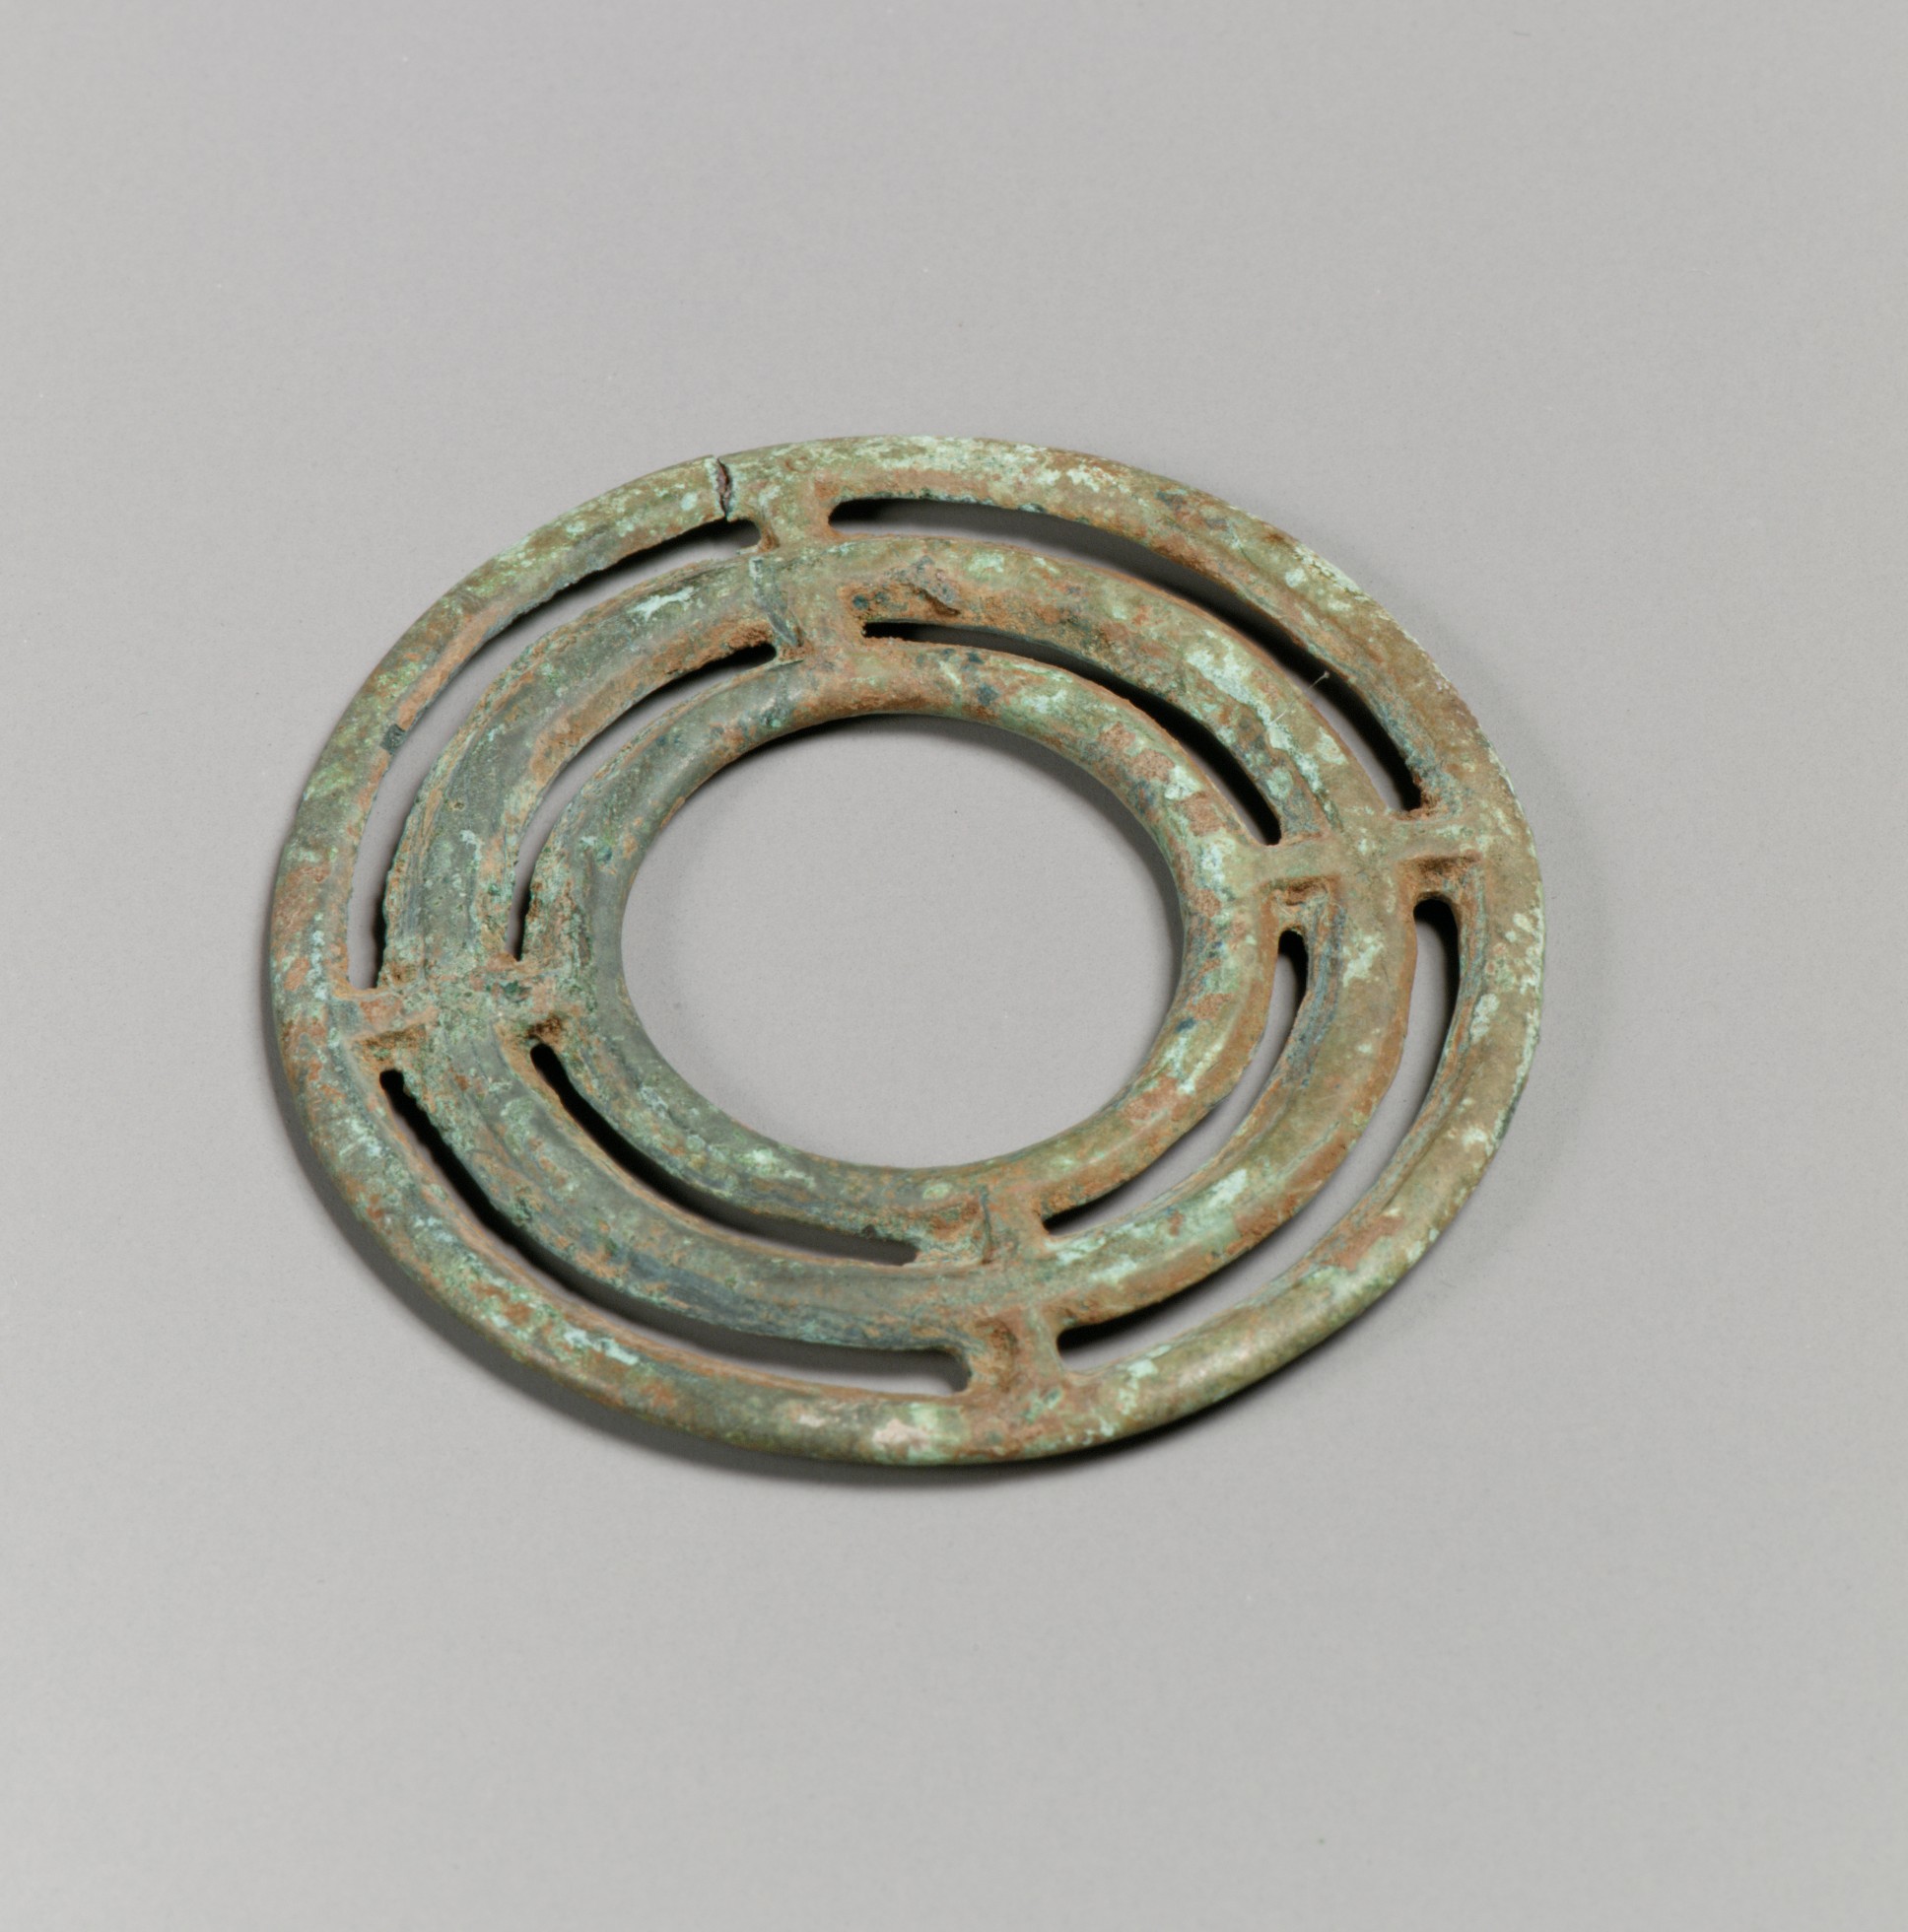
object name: necklace spiral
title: Bronze necklace spiral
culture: italic, villanovan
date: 900-701 BCE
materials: bronze